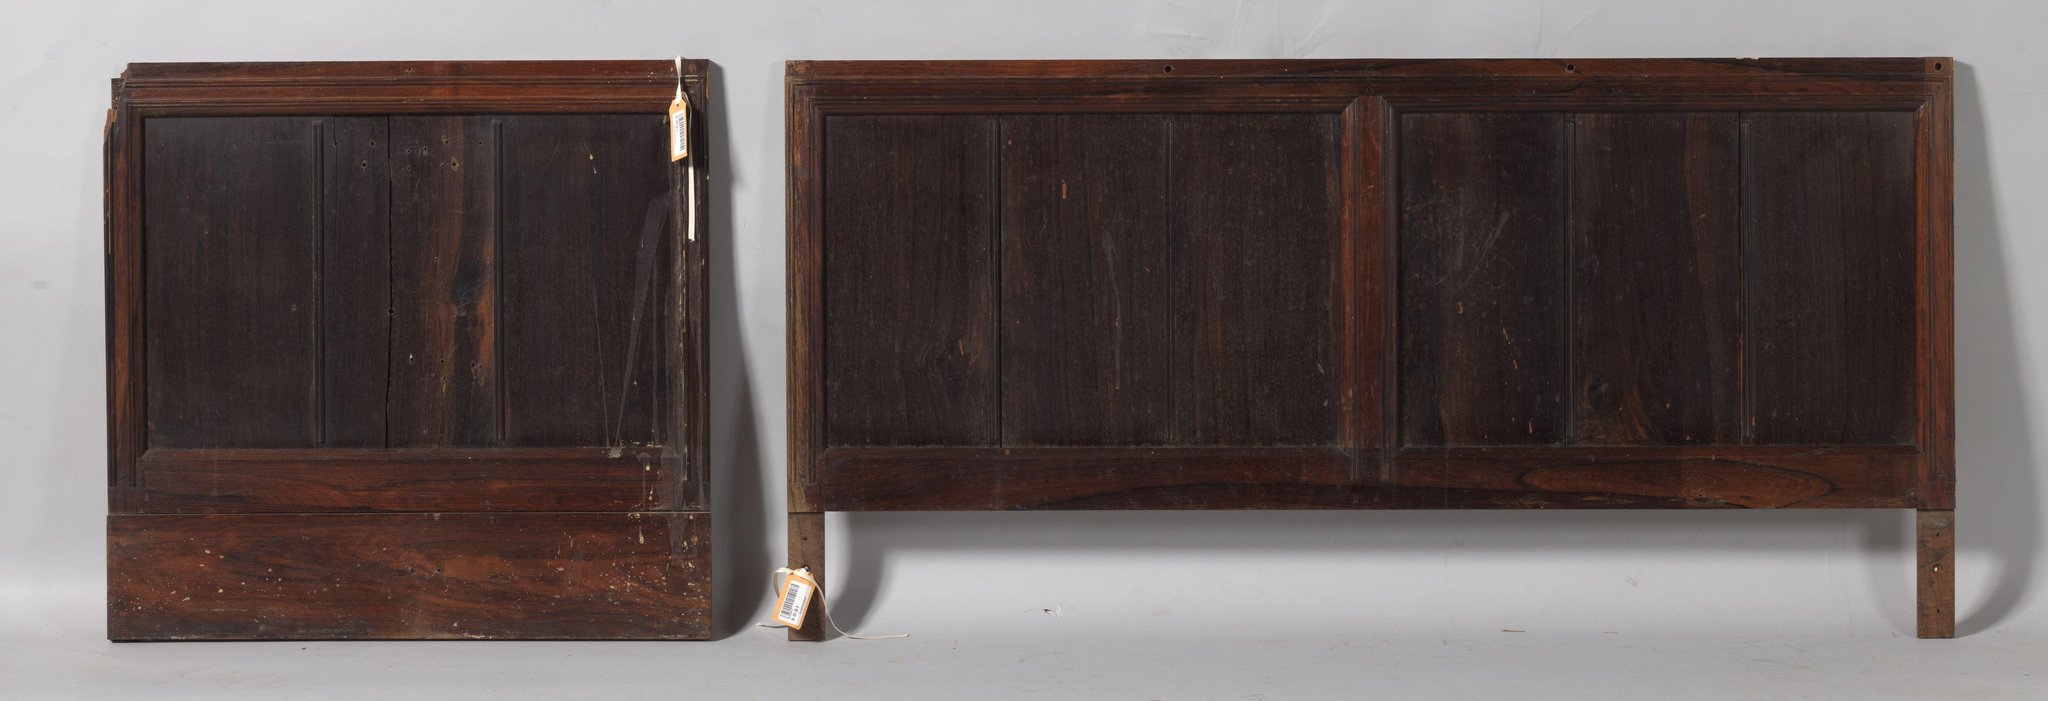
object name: betimmering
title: Schot van betimmering uit huis Dentz van Schaick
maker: carel adolph lion cachet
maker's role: draughtsman, print maker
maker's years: 1864-1945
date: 1900-1905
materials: wood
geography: amsterdam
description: Schot, onderdeel van betimmering vervaardigd voor het huis van mr Th.G. Dentz van Schaick aan het Amsterdamse Frederiksplein 50-52. gemerkt met potlood: AB6D3.